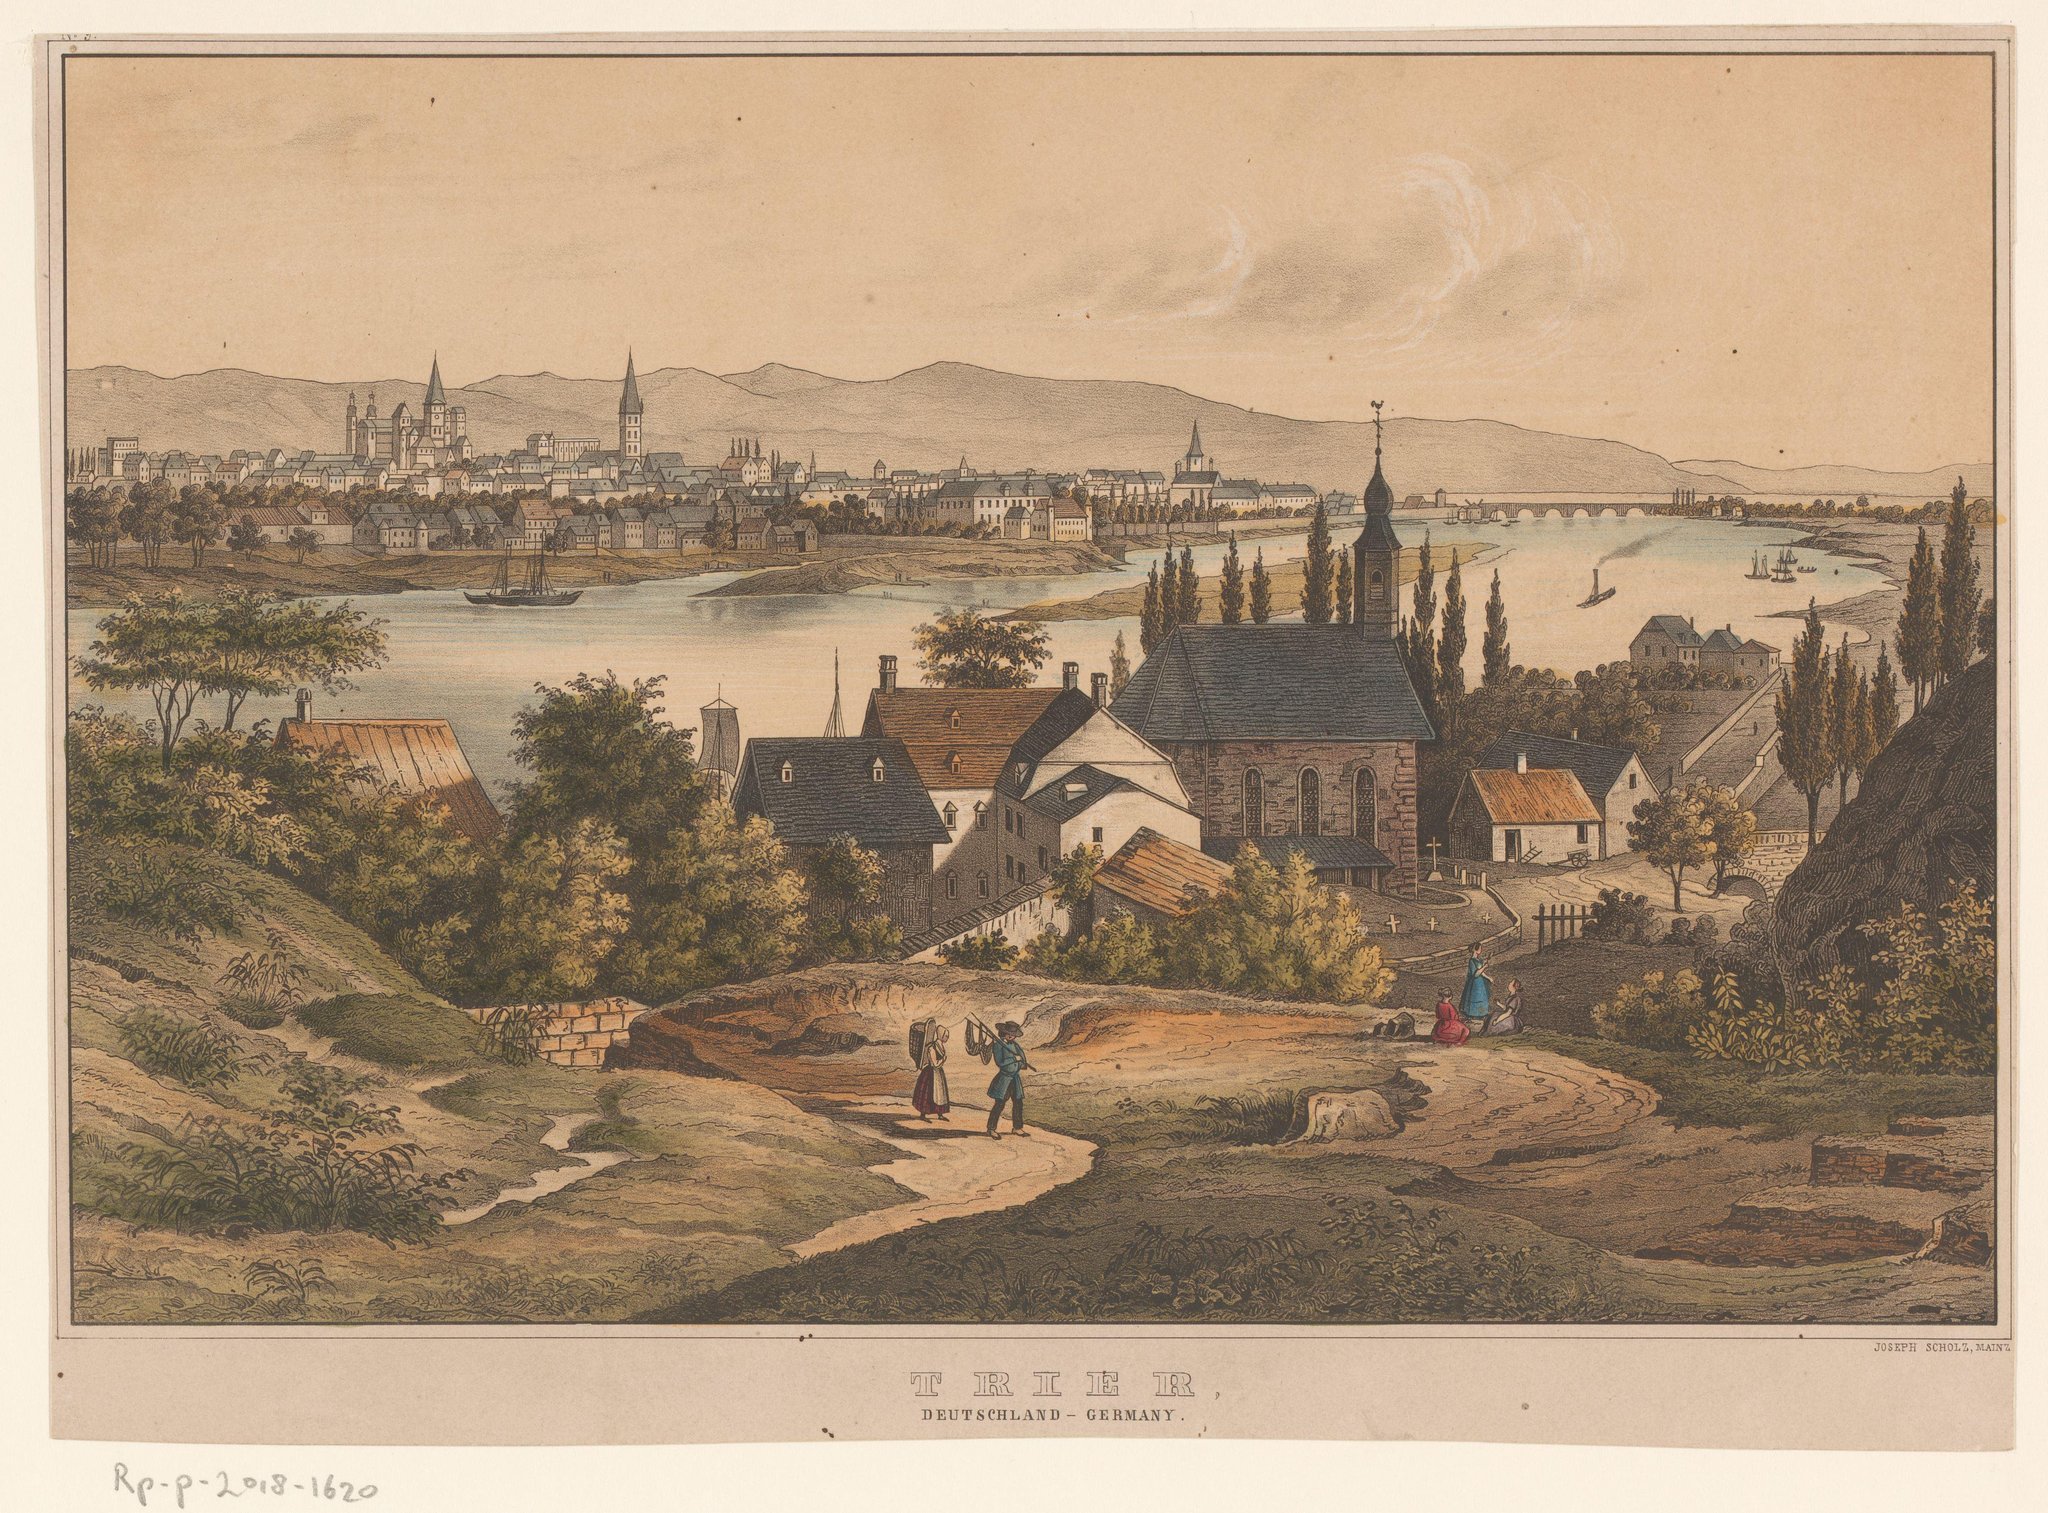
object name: print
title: Trier, Deutschland - Germany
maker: Anonymous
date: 1829-1880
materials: paper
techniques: lithograph, hand coloring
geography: mainz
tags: prospect of city, town panorama, silhouette of city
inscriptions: collector's mark: Lugt 2228